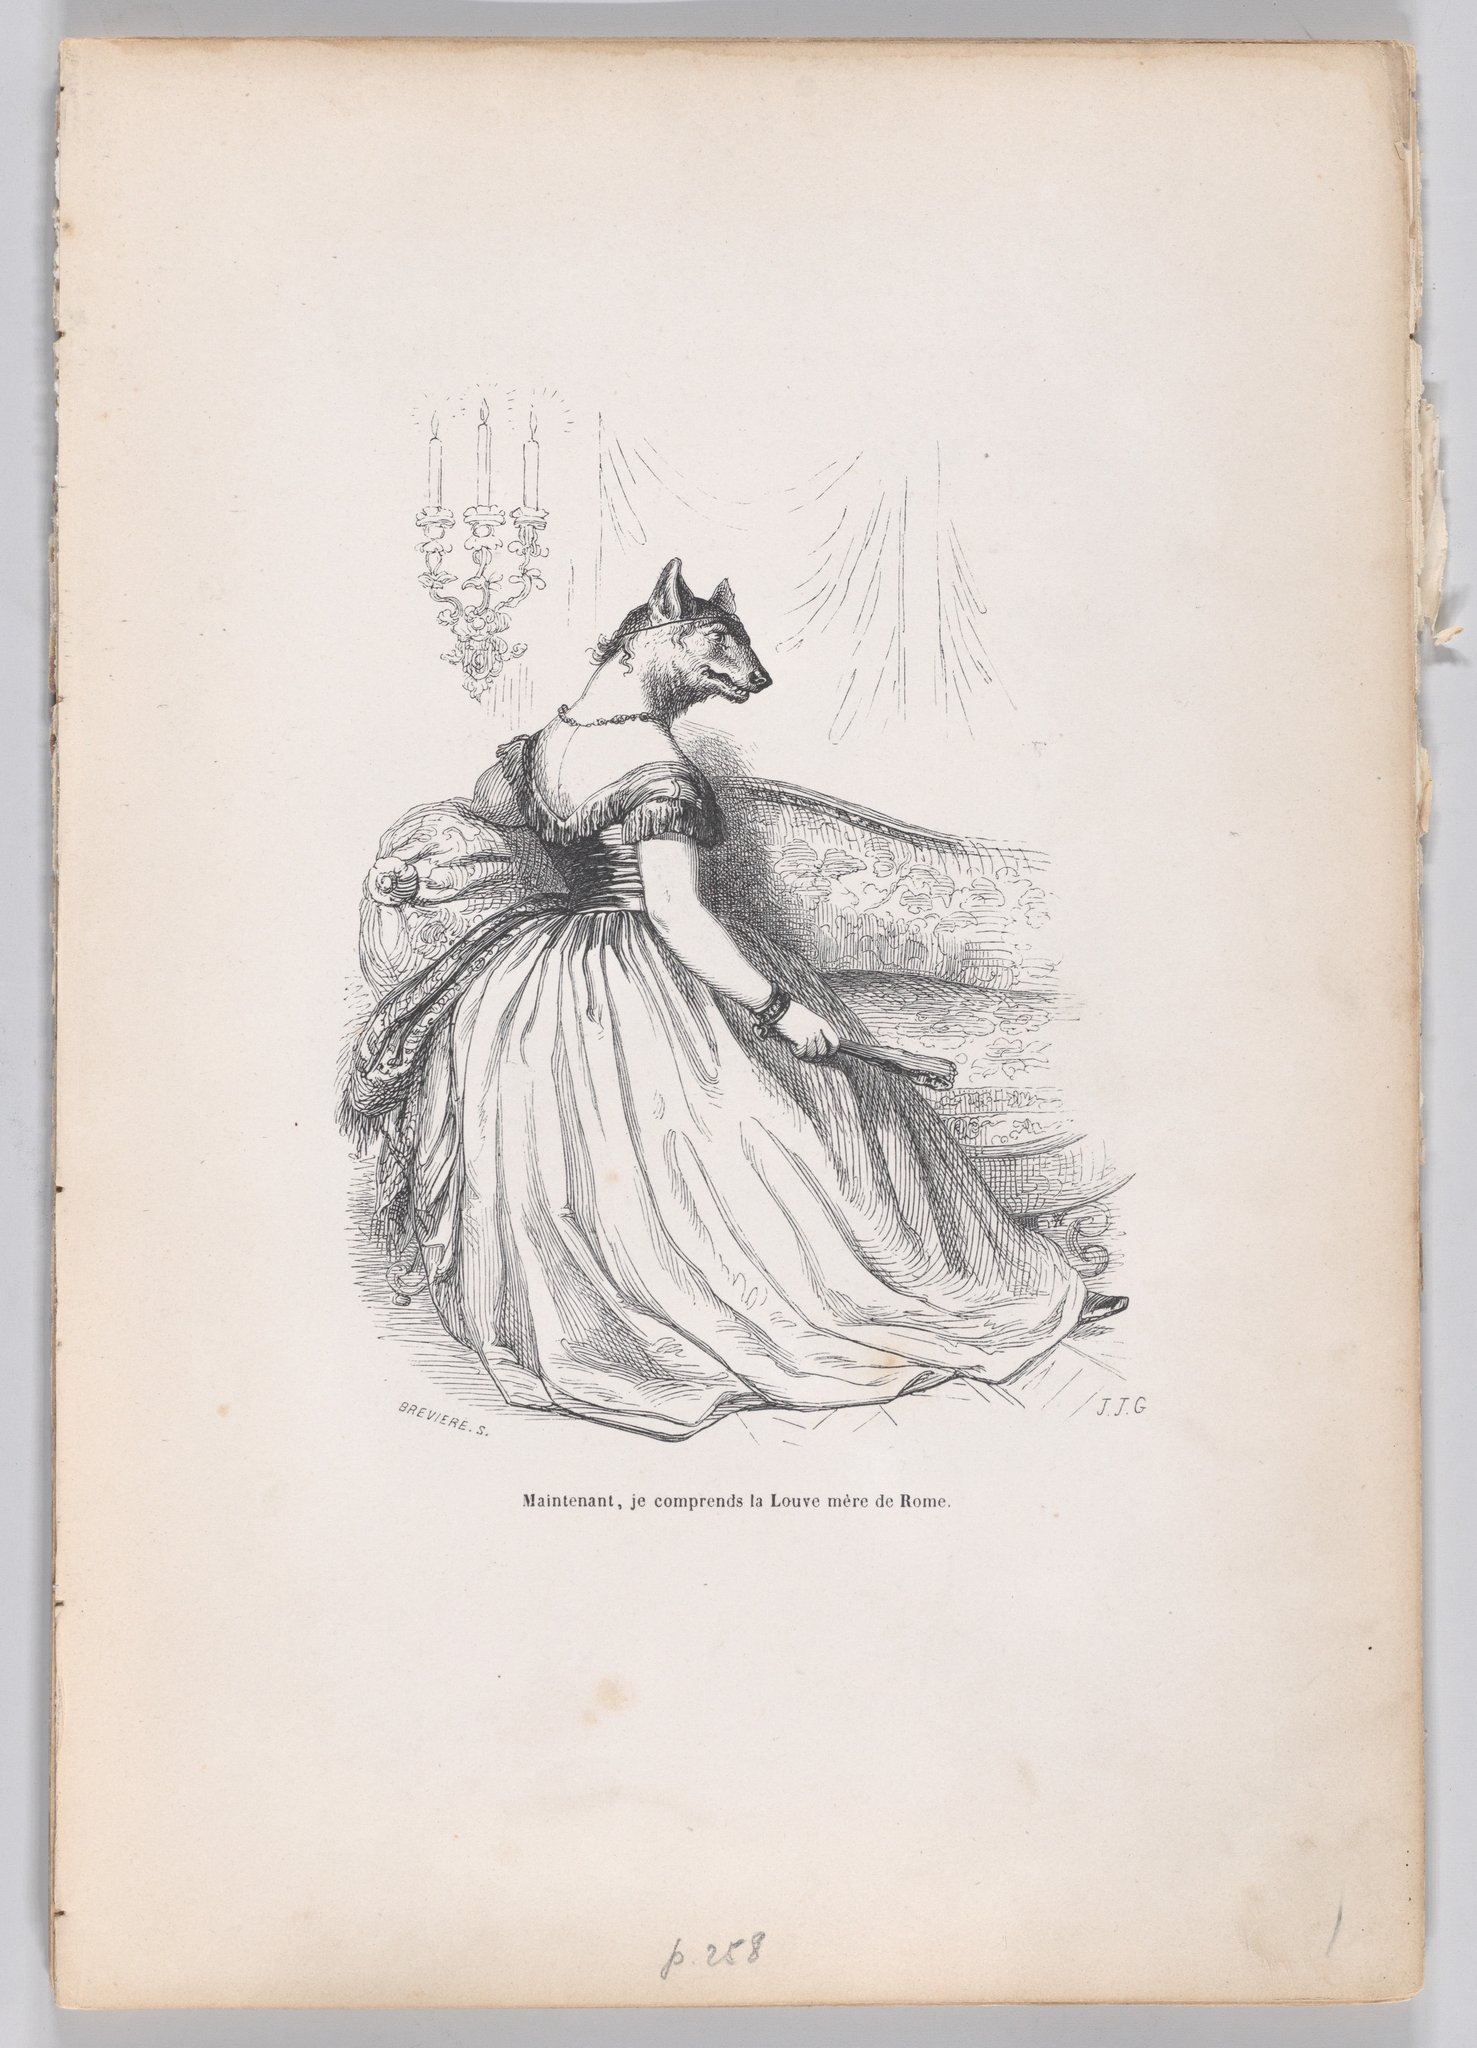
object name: print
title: Now, I understand the mother wolf of Rome, from "Scenes from the Private and Public Life of Animals"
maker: j. j. grandville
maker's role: illustrator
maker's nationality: french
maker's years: 1803-1847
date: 1837-1847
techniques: engraving